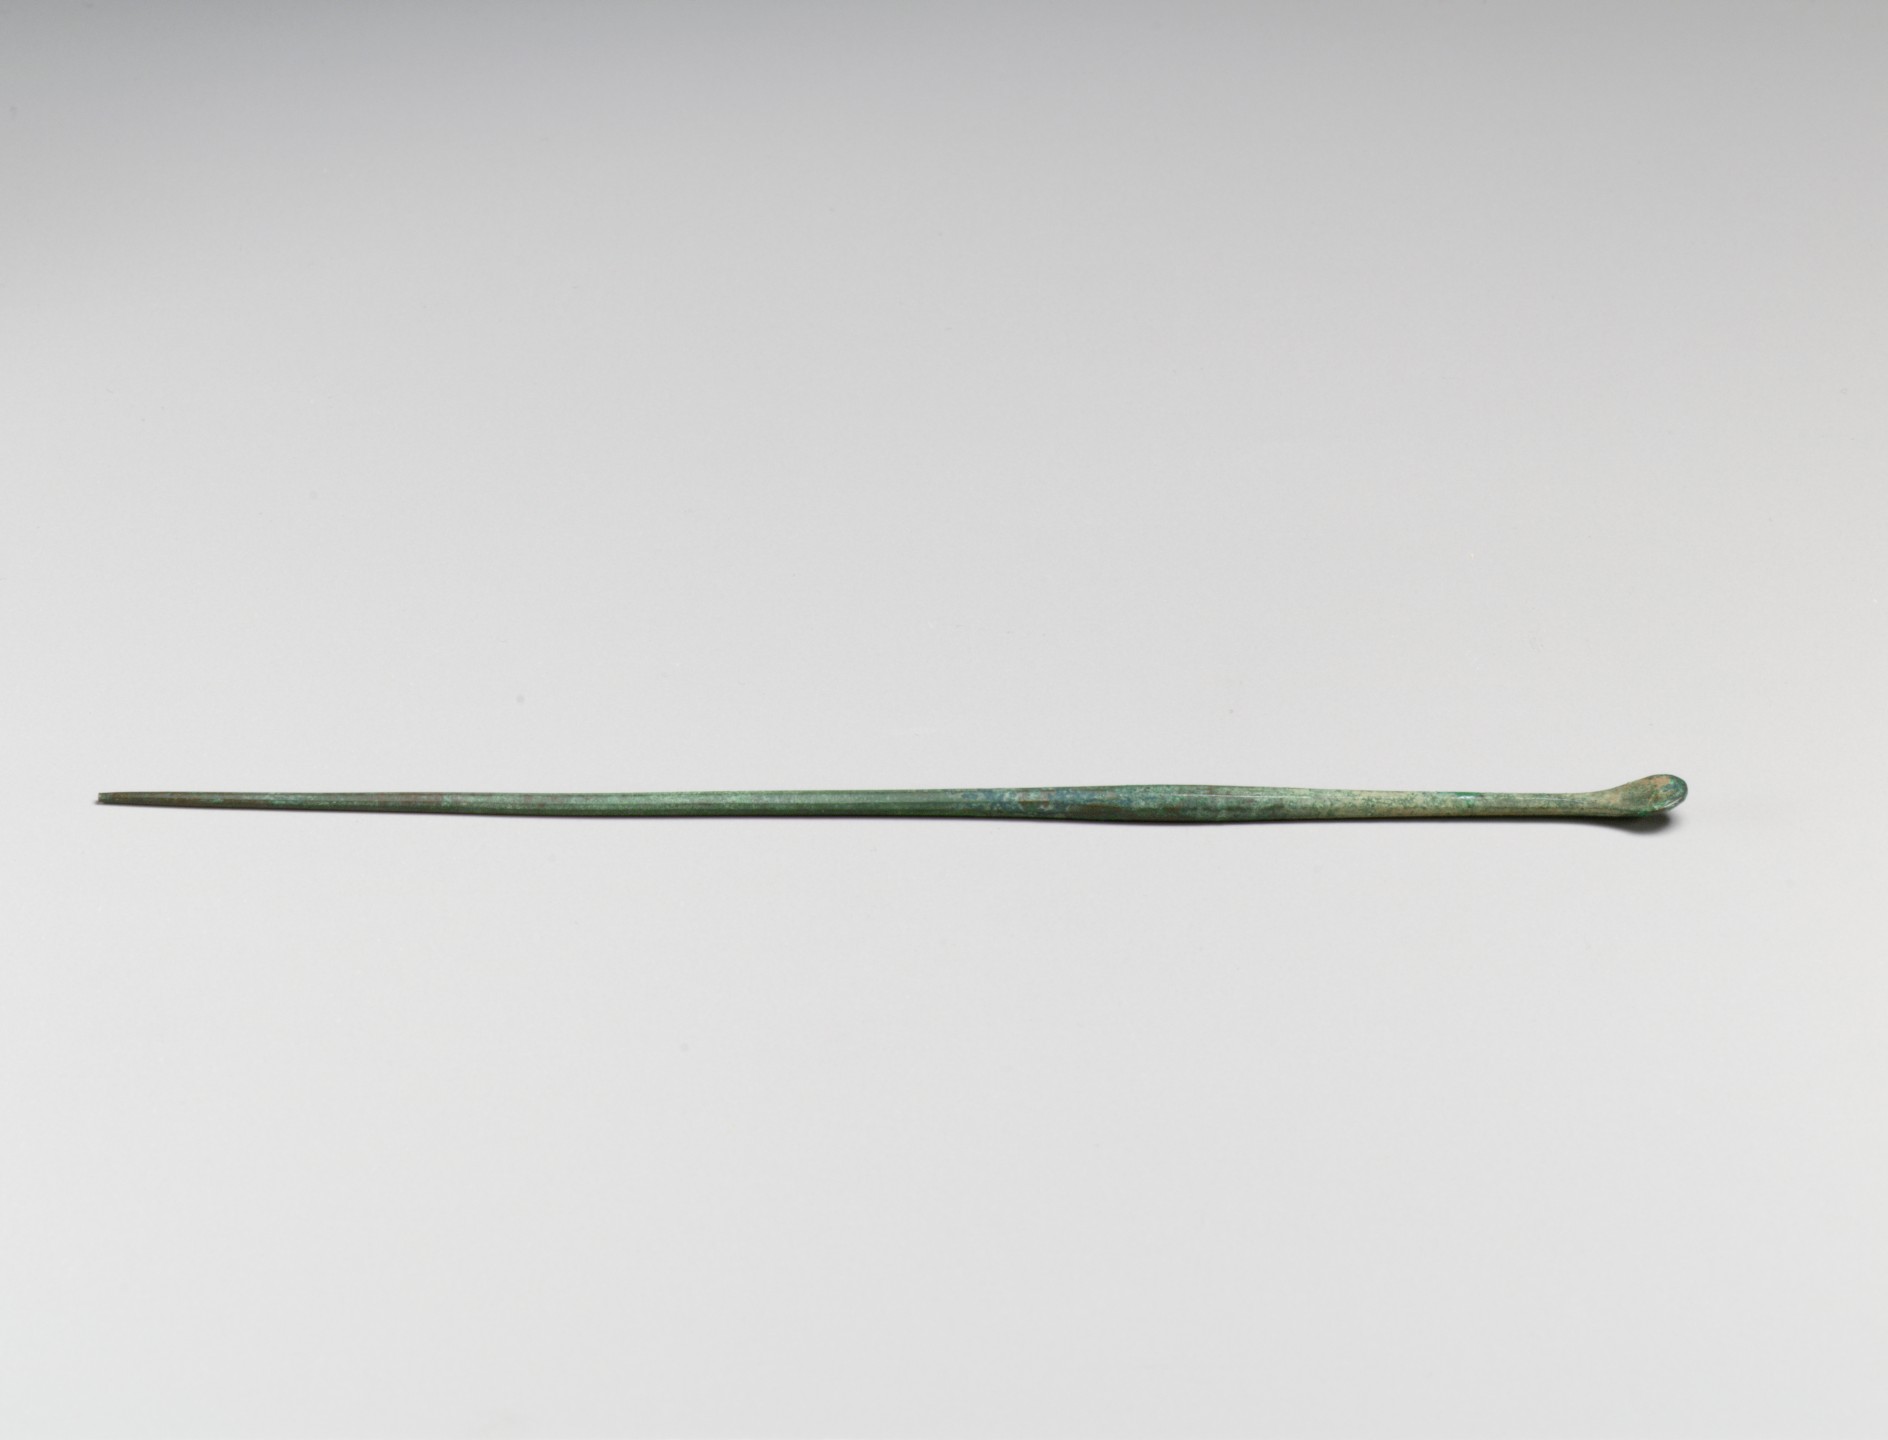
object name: ear probe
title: Ear probe ?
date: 7000 BCE-330 CE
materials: bronze